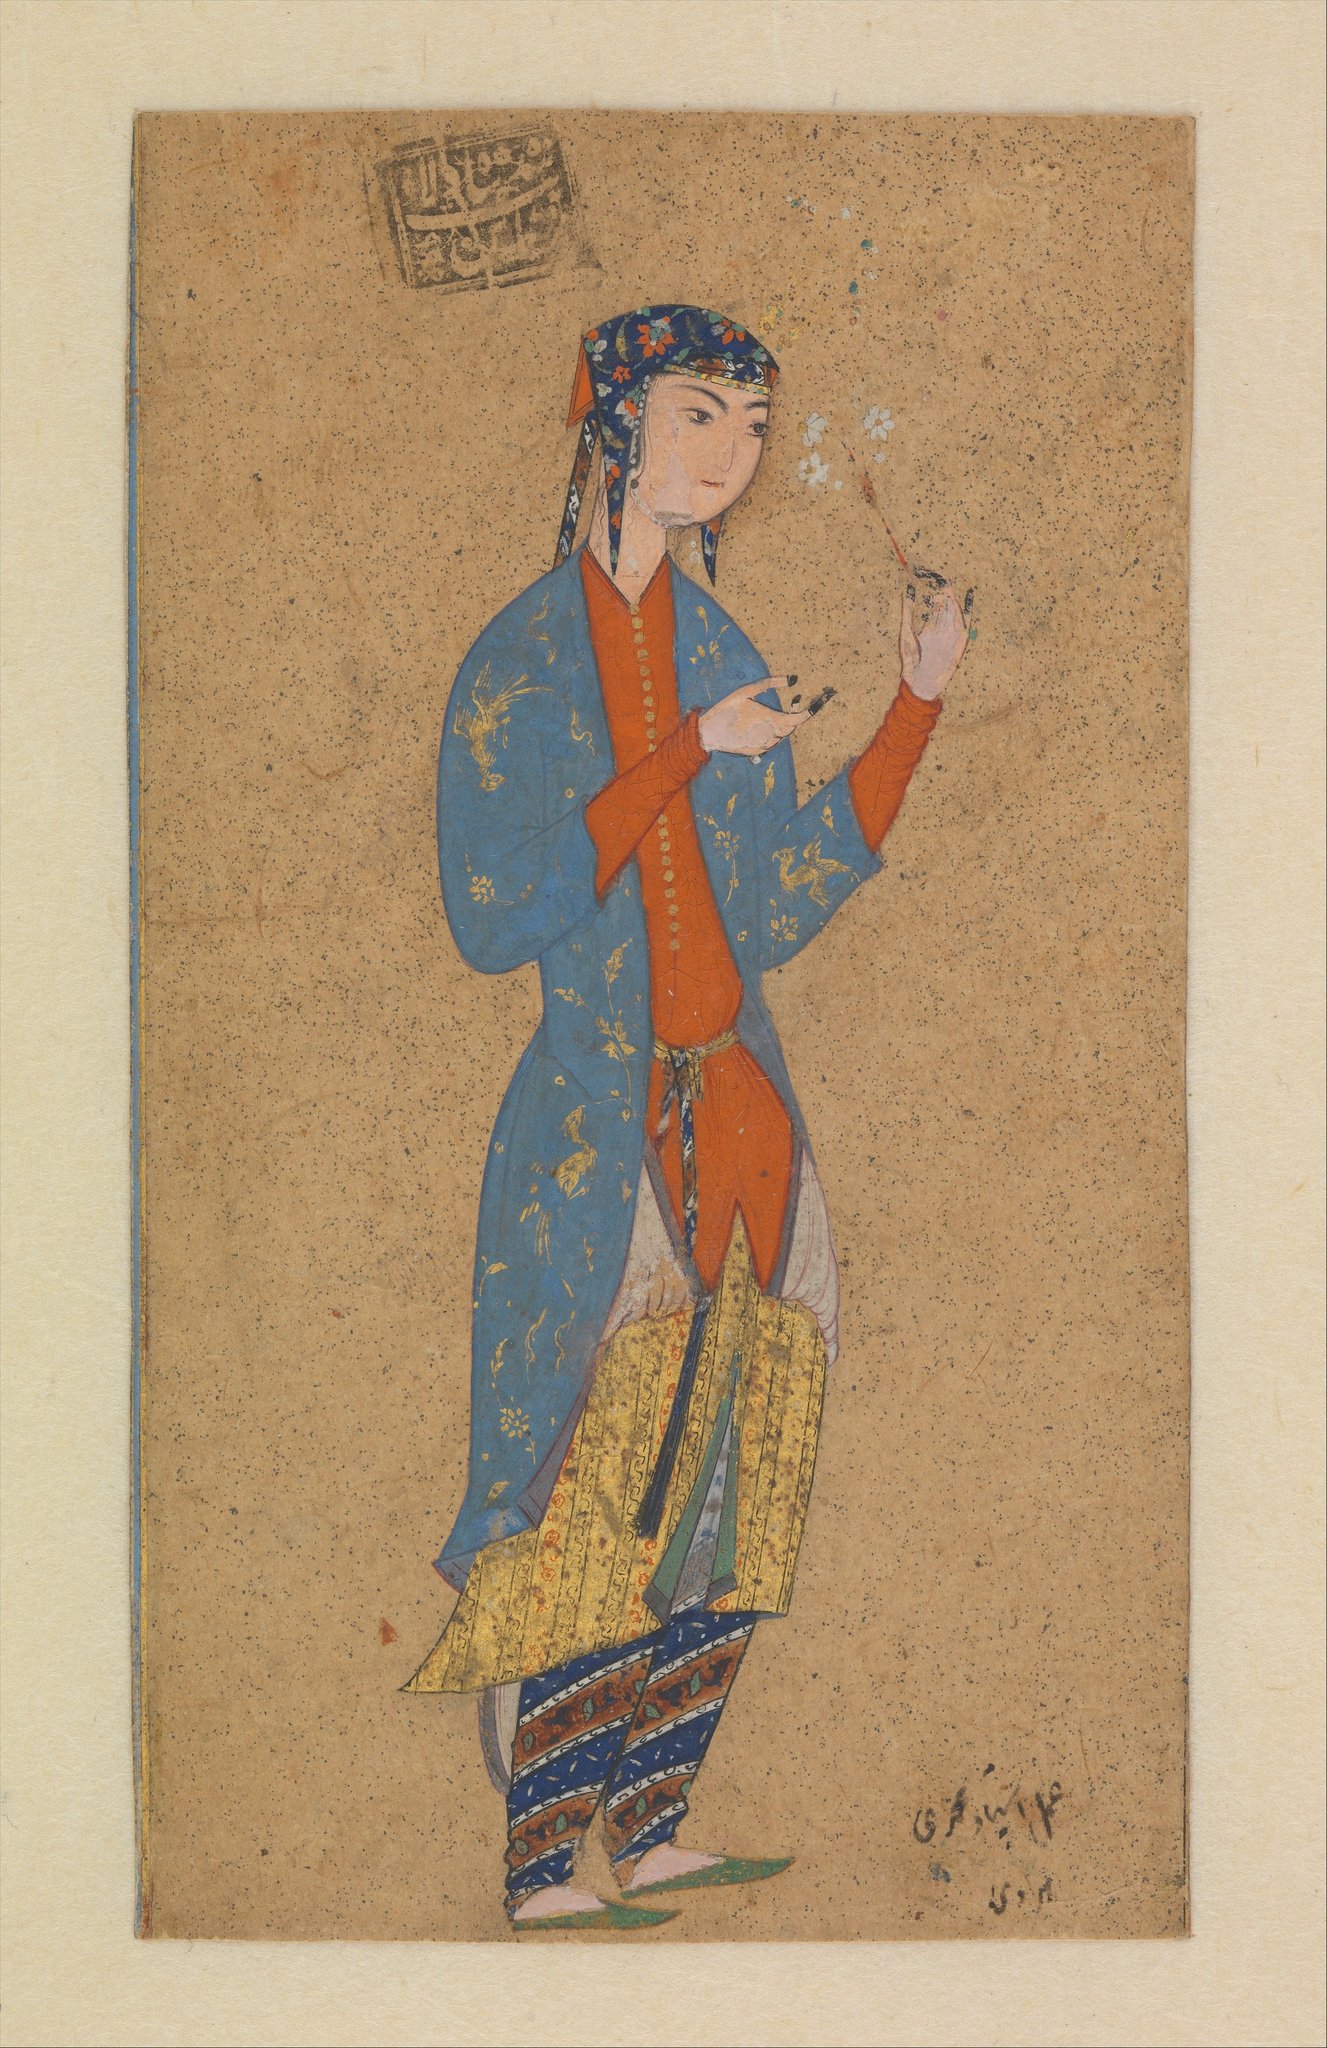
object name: illustrated single work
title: Portrait of a Lady Holding a Flower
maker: muhammadi of herat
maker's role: artist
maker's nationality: iranian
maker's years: 1545-1613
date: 1565-1575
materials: gold, ink, paper, watercolor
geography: afghanistan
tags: portraits,women,daisies